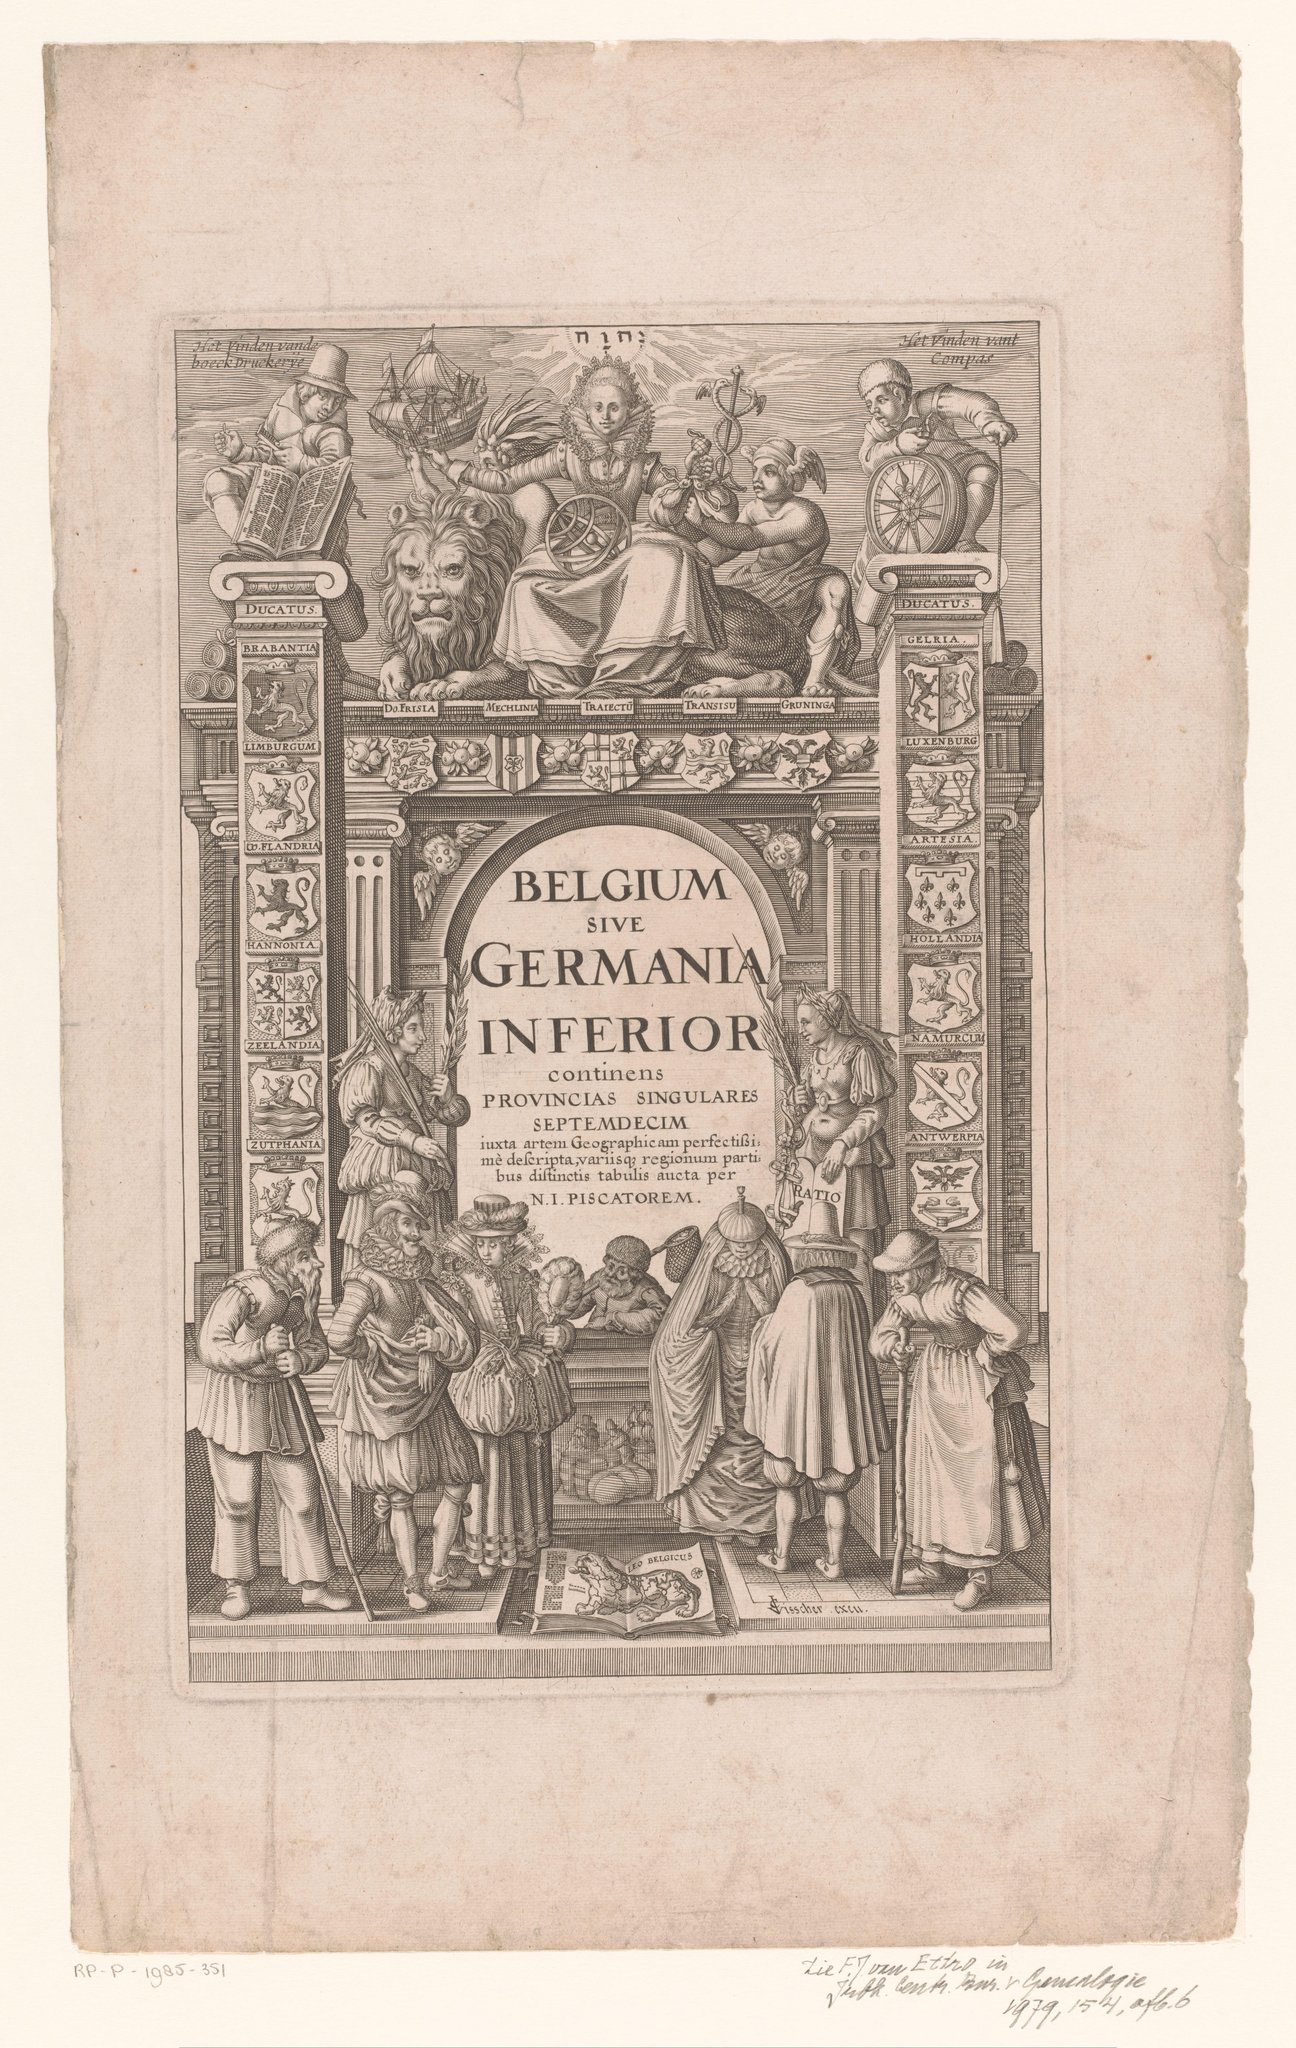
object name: print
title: Titelpagina voor: Claes Jansz Visscher, Belgium sive Germania inferior (...), 1634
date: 1634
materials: paper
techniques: engraving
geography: amsterdam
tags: coat of arms (as symbol of the state, etc.), provincial government, triumphal arch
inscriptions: inscription: ‘28-11-85 / 1 + 2 + 12’, collector's mark: Lugt 2760, collector's mark: Lugt 2228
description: In het midden een triomfboog met de titel van de atlas, geflankeerd door twee vrouwen. De vrouw rechts houdt een bezem en een bord met 'ratio' in haar handen en de vrouw links heeft een palmtak en een olijftak vast. De boog is gedecoreerd met de wapens van De Zeventien Provinciën. Op de boog zit een rijk geklede vrouw op een leeuw. Zij is omringd met attributen die de welvaart van de provinciën representeren, zoals de mercuriusstaf, een boot en het armillarium op haar schoot. Rechts naast haar zit Mercurius en links achter haar houdt Neptunus een boot vast. Het drietal wordt geflankeerd door een personificatie van de uitvinding van de boekdrukkunst, links, en een personificatie van de ontdekking van het kompas, rechts. Op de voorgrond staan een arme man en vrouw en twee adellijke paren.